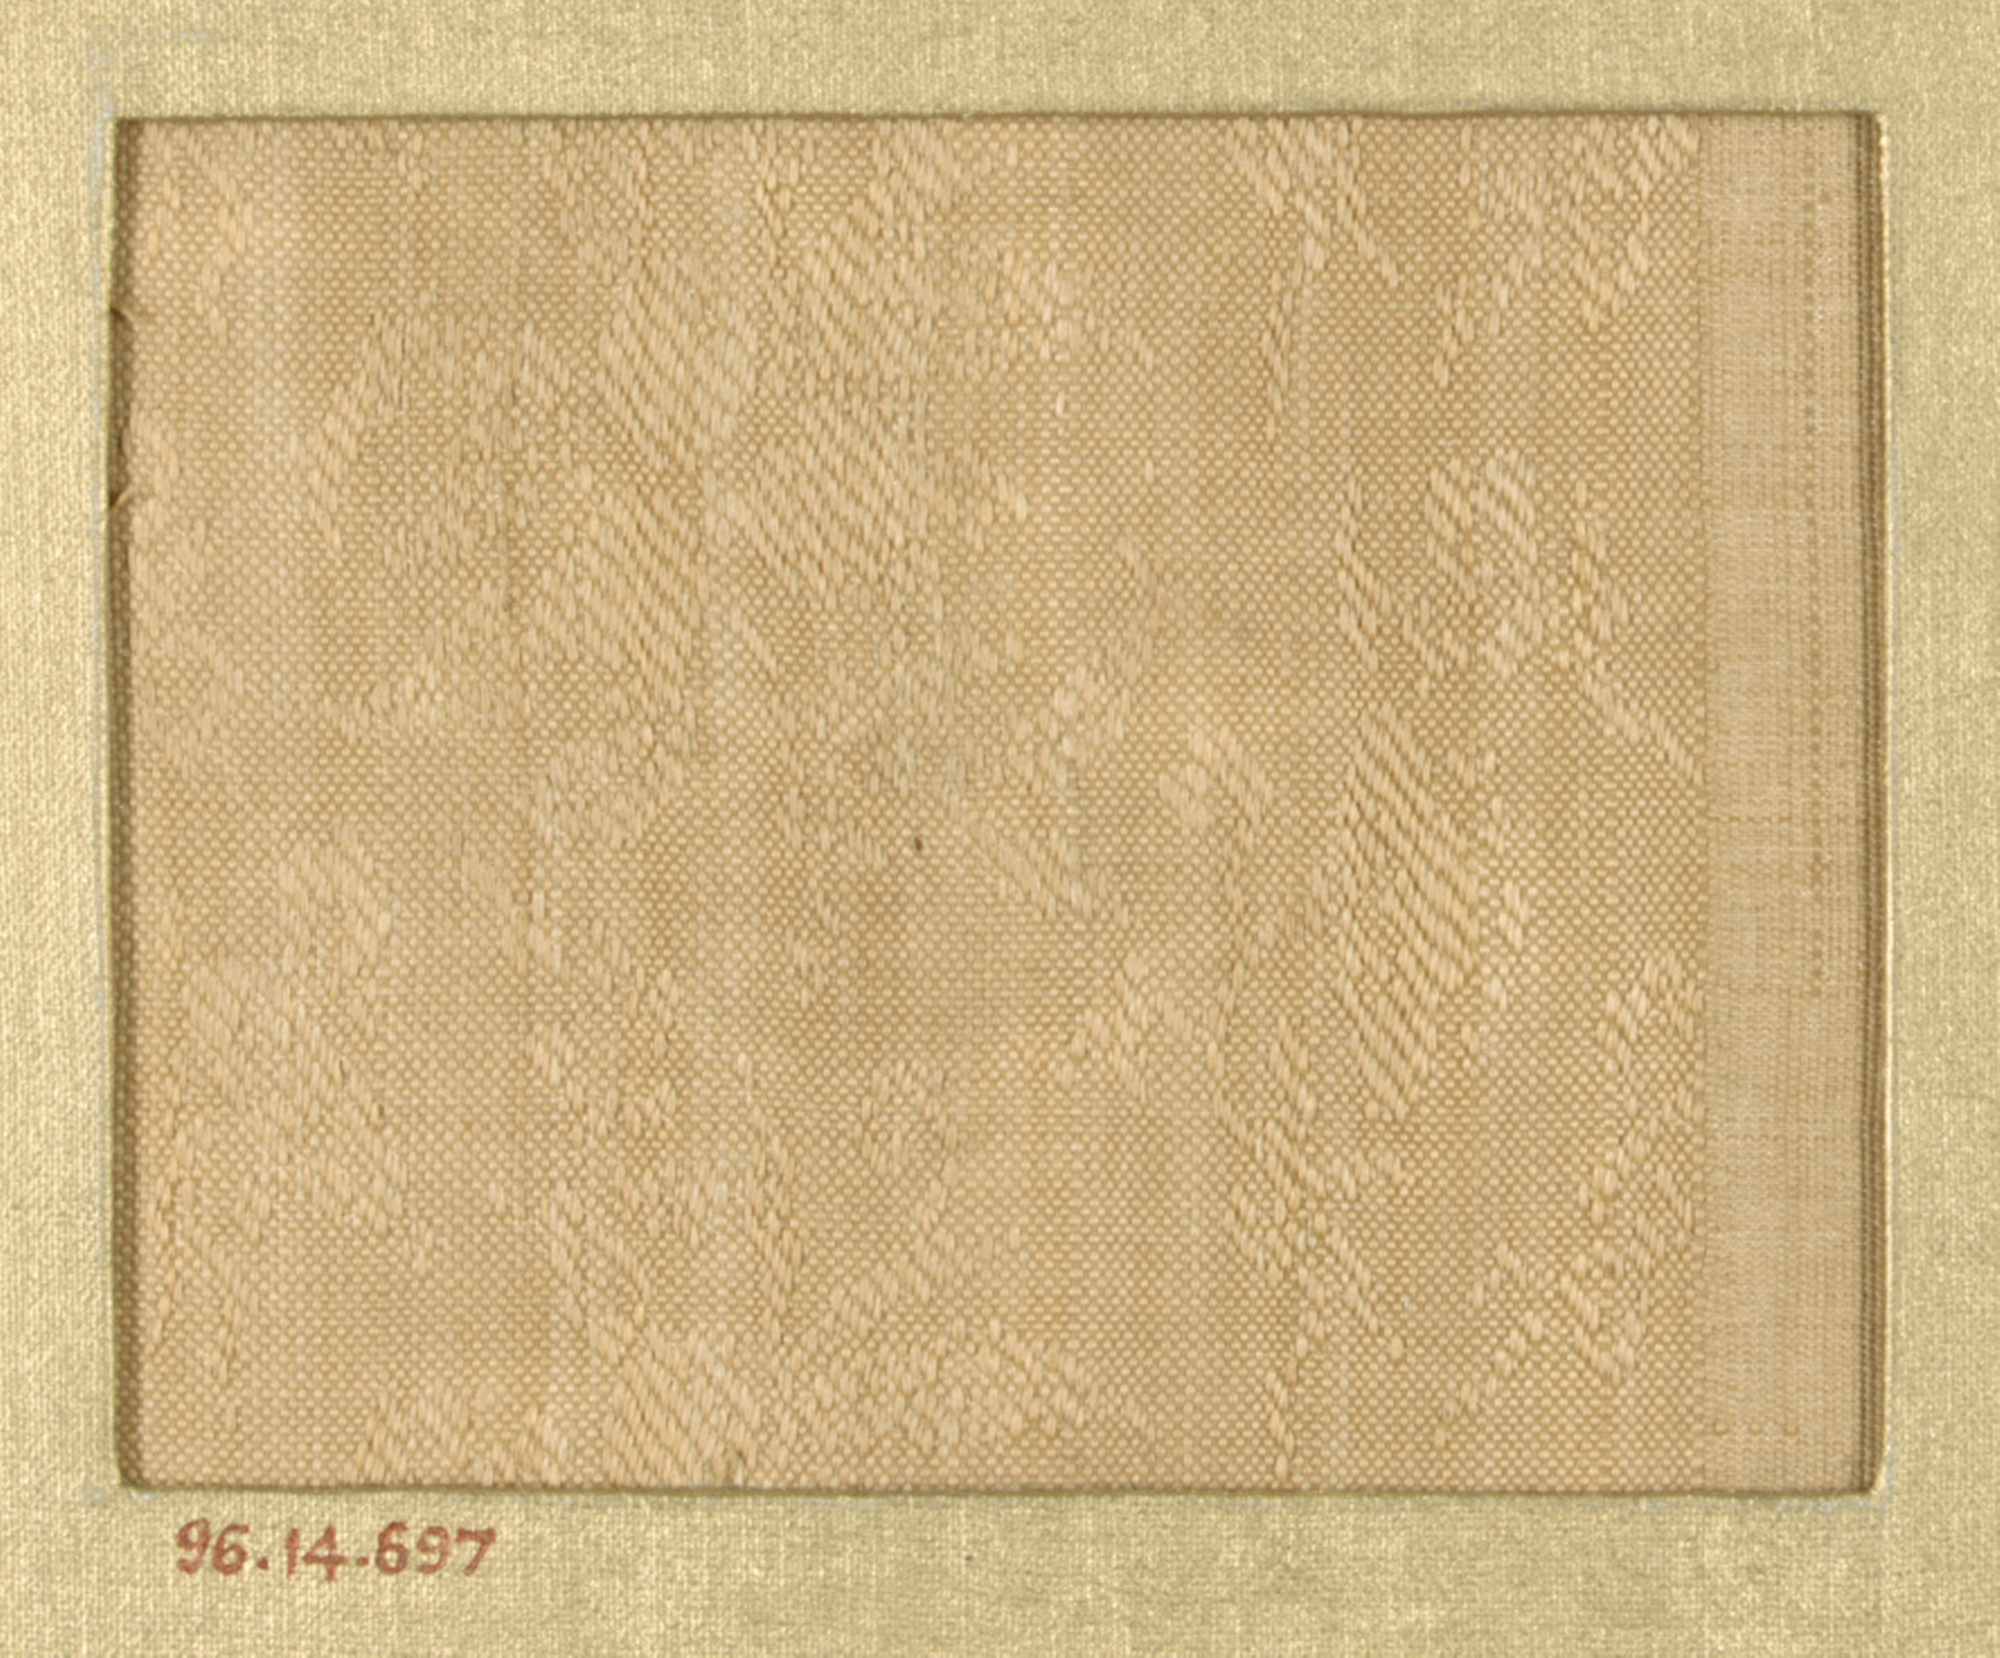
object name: piece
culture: japanese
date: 1701-1900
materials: silk